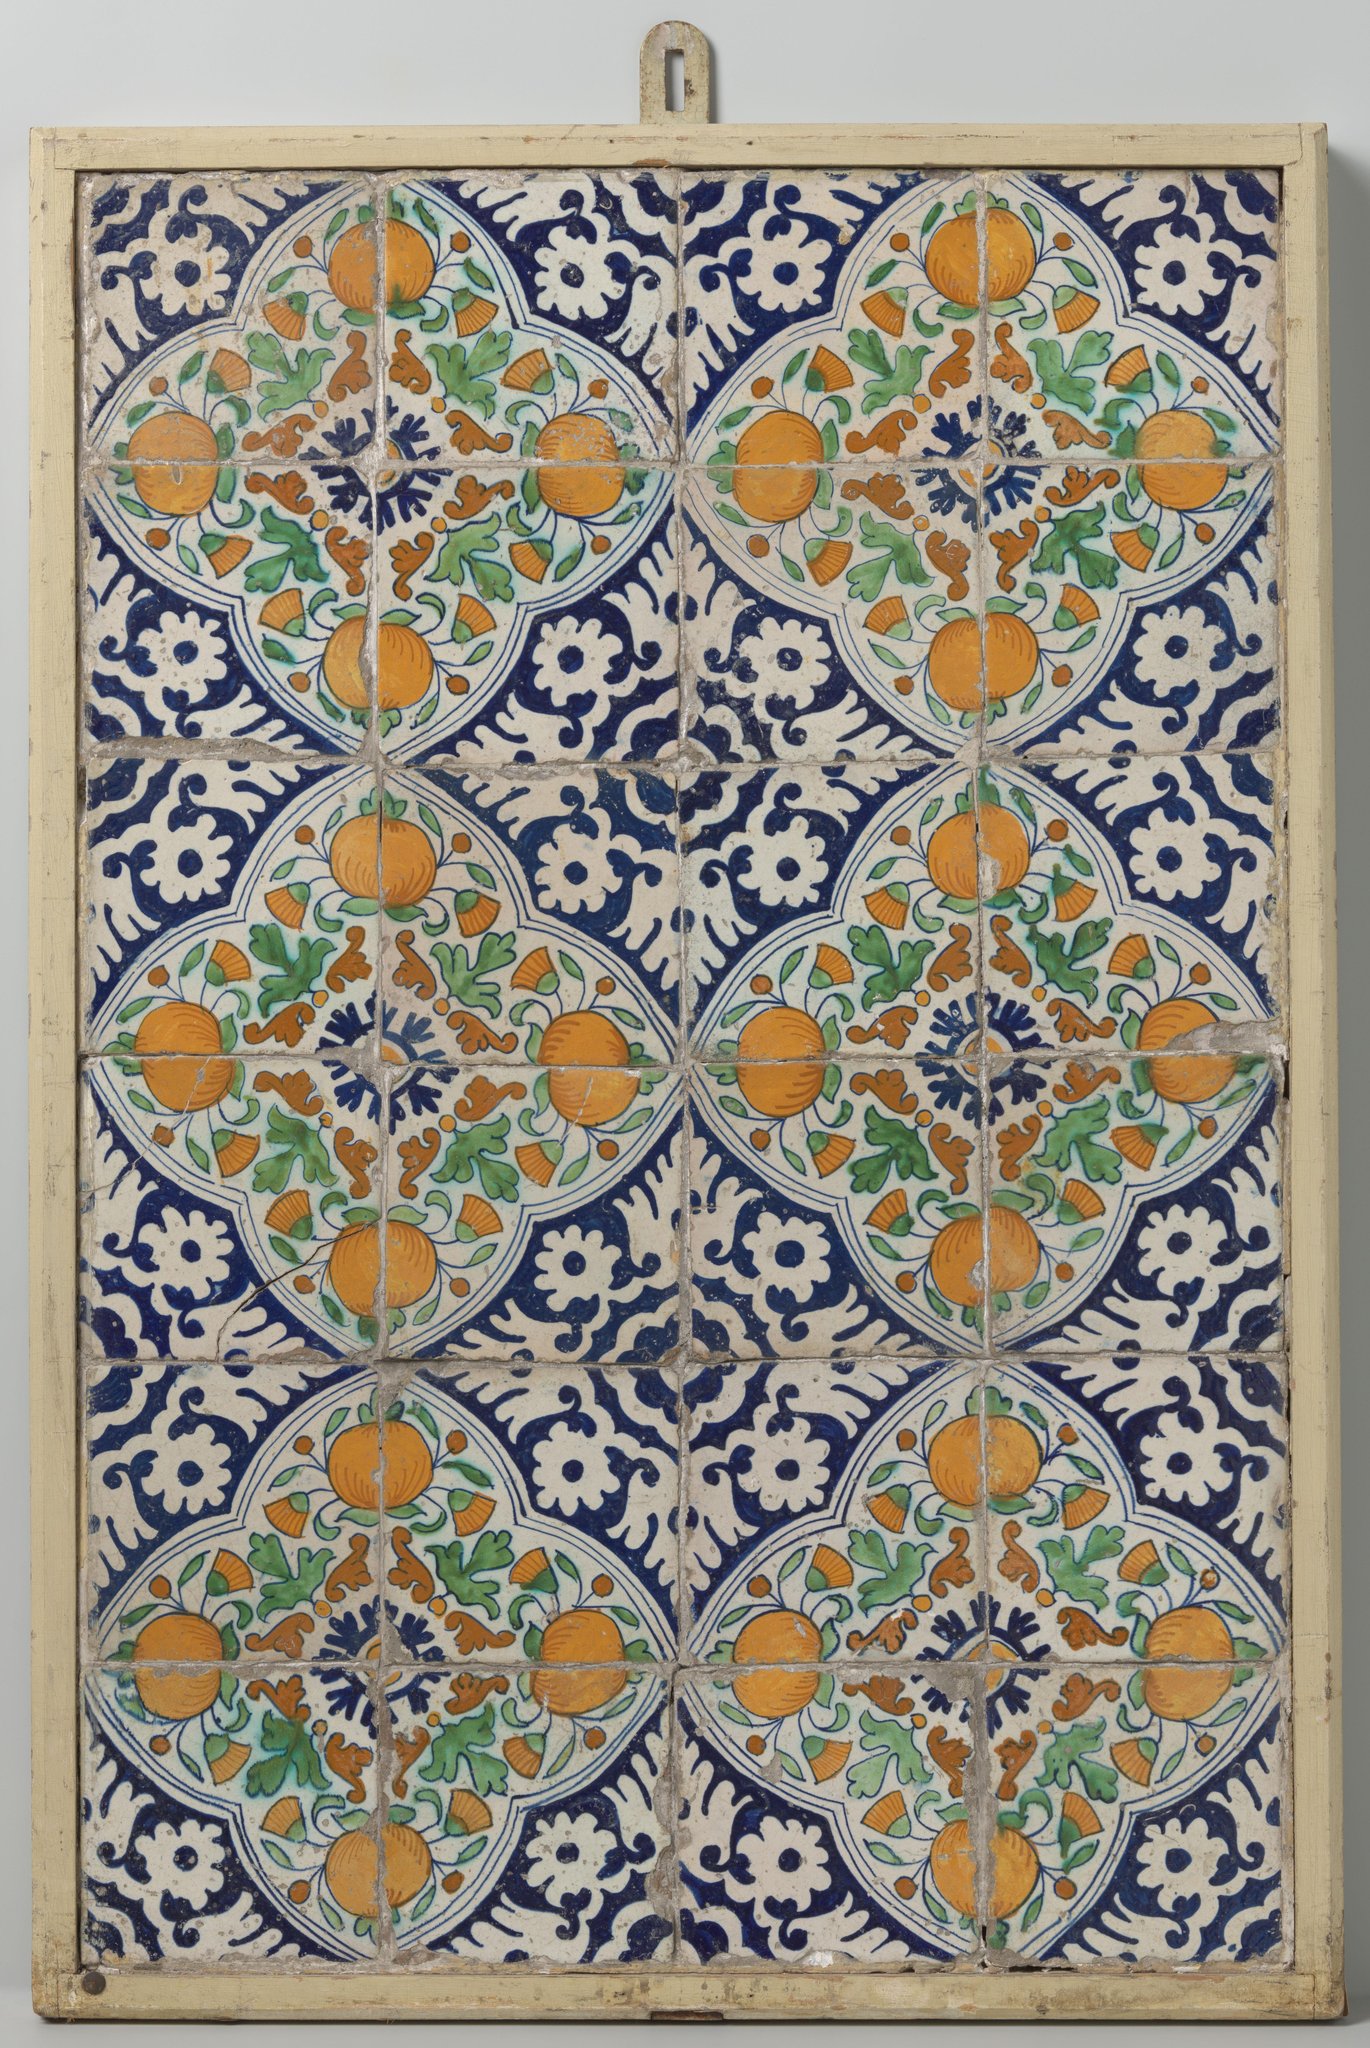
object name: vierpastegel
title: 24 Vierpastegels in tegelveld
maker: Anonymous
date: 1580-1620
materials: earthenware, glaze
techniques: maiolica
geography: netherlands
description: 24 vierpastegels geplaatst in tegelveld van 6 x 4. Vier tegels vormen samen een vierpas met rozet omgeven door granaatappels en goudsbloemen. In de hoeken, ornament in vultechniek.